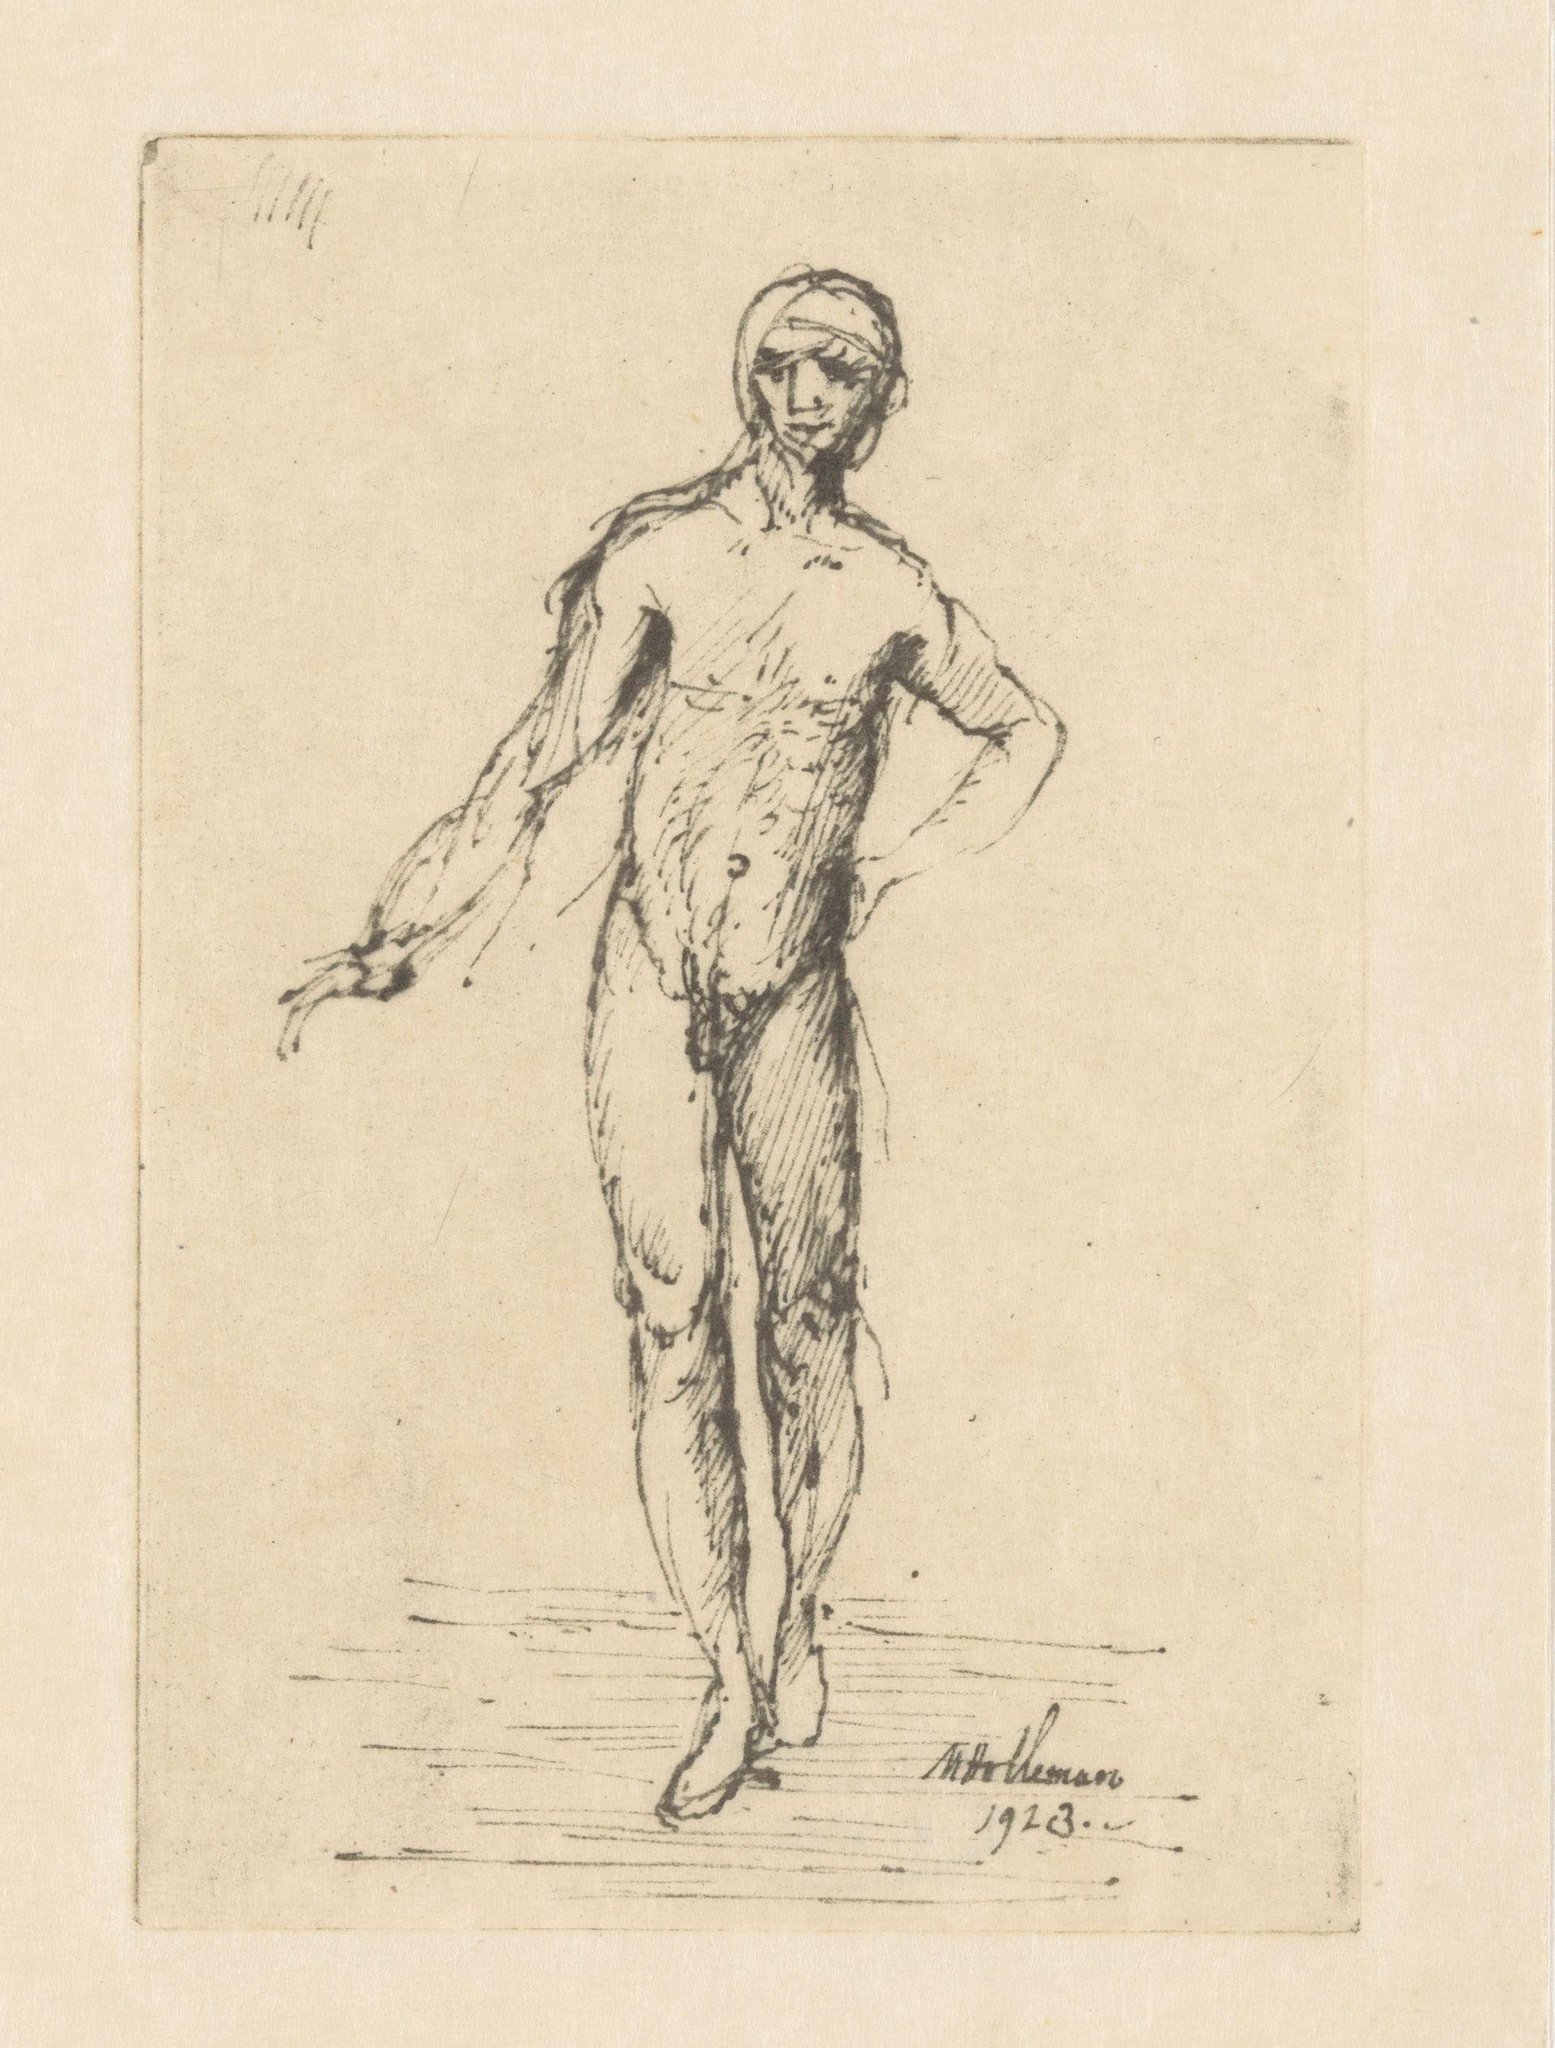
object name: print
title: Staand mannelijk naakt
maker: marius holleman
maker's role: draughtsman, print maker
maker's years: 1878-1926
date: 1923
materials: paper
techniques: etching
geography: groningen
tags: hand on the hip, man (showing himself) undressed, quasi-nude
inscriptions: collector's mark: Lugt 2228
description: De man heeft zijn linkerhand in zijn zij.